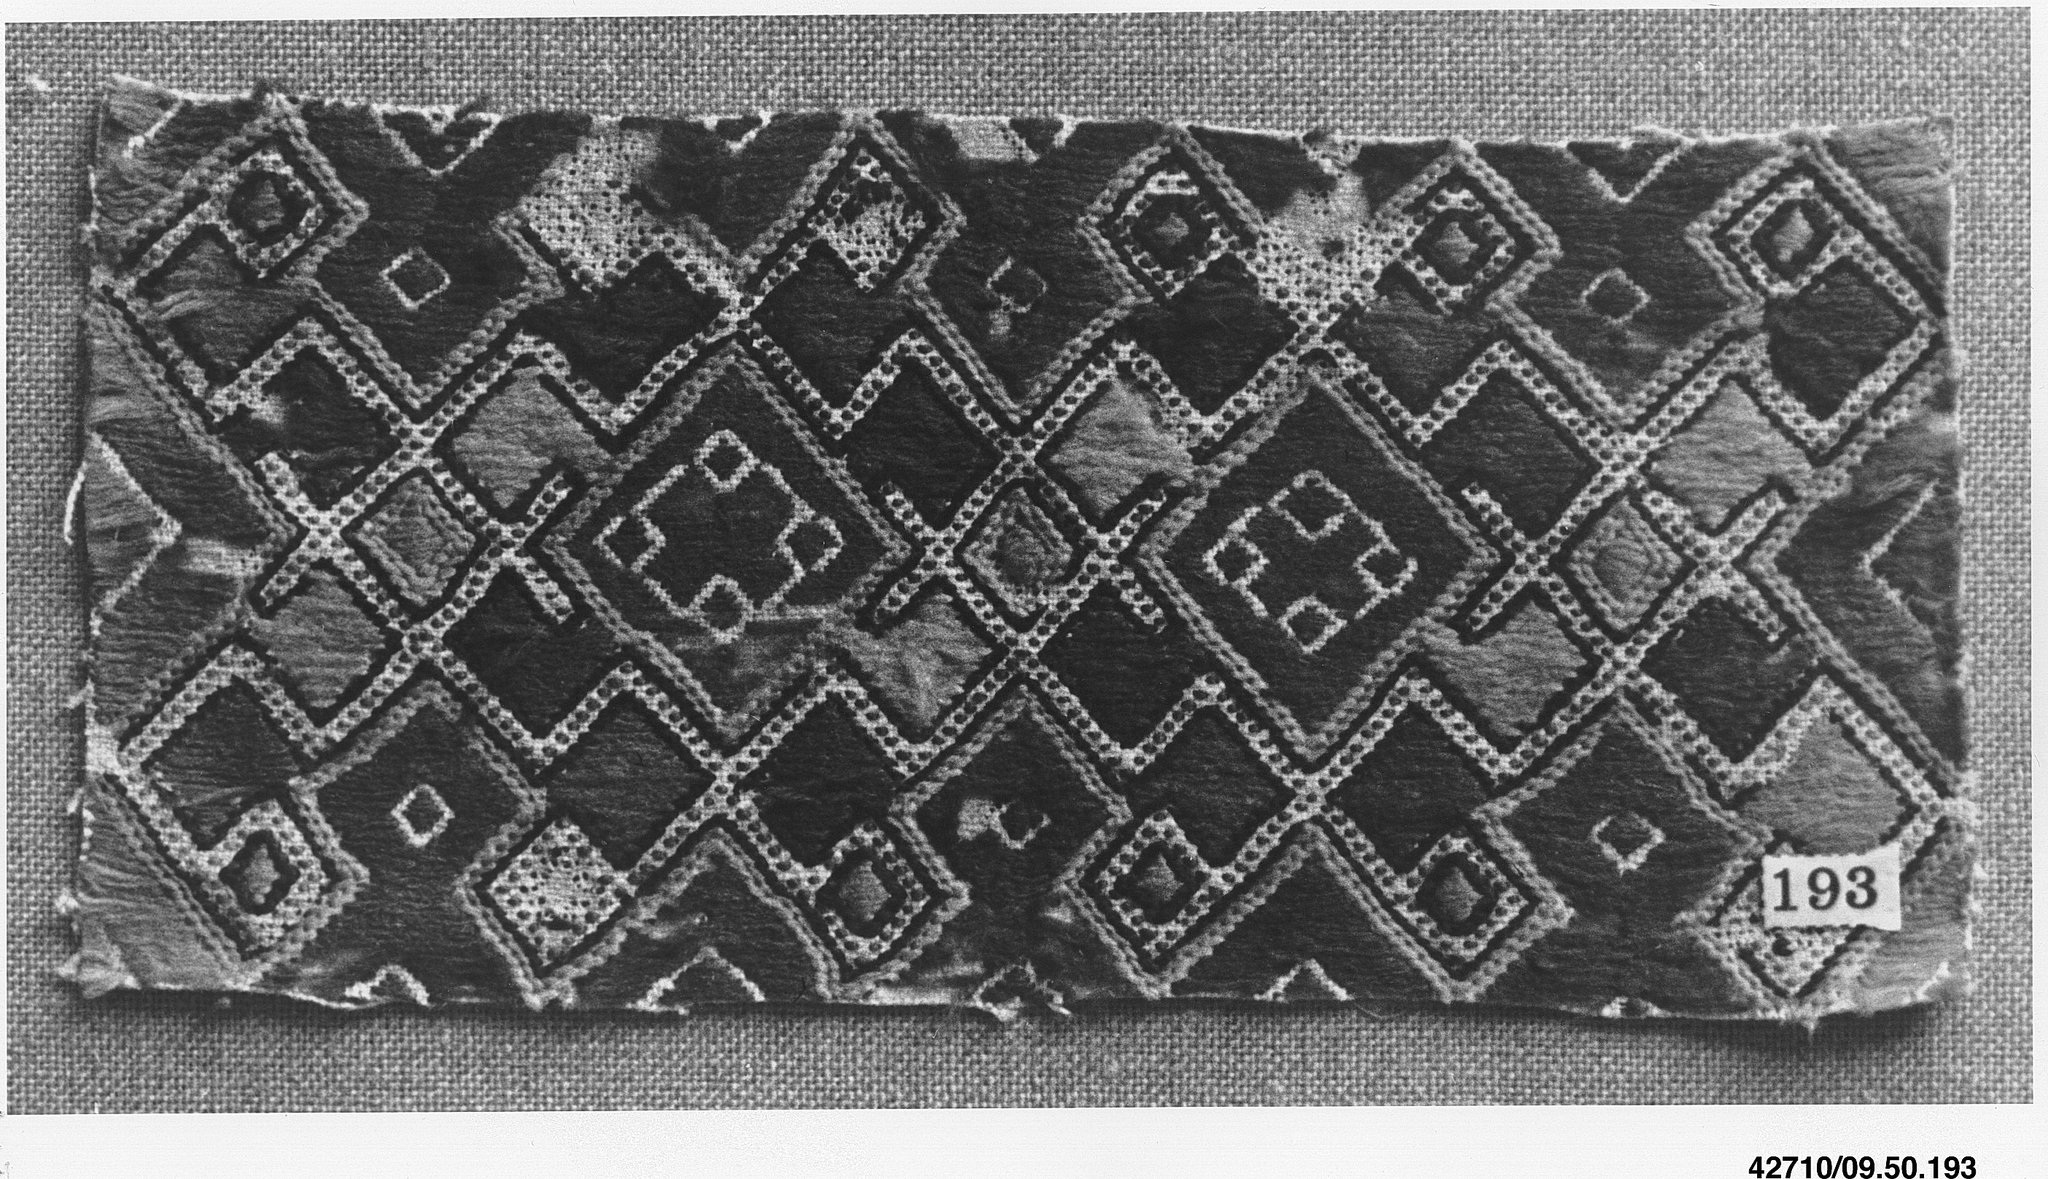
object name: costume fragment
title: Peasant costume fragment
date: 1701-1900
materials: canvas, wool